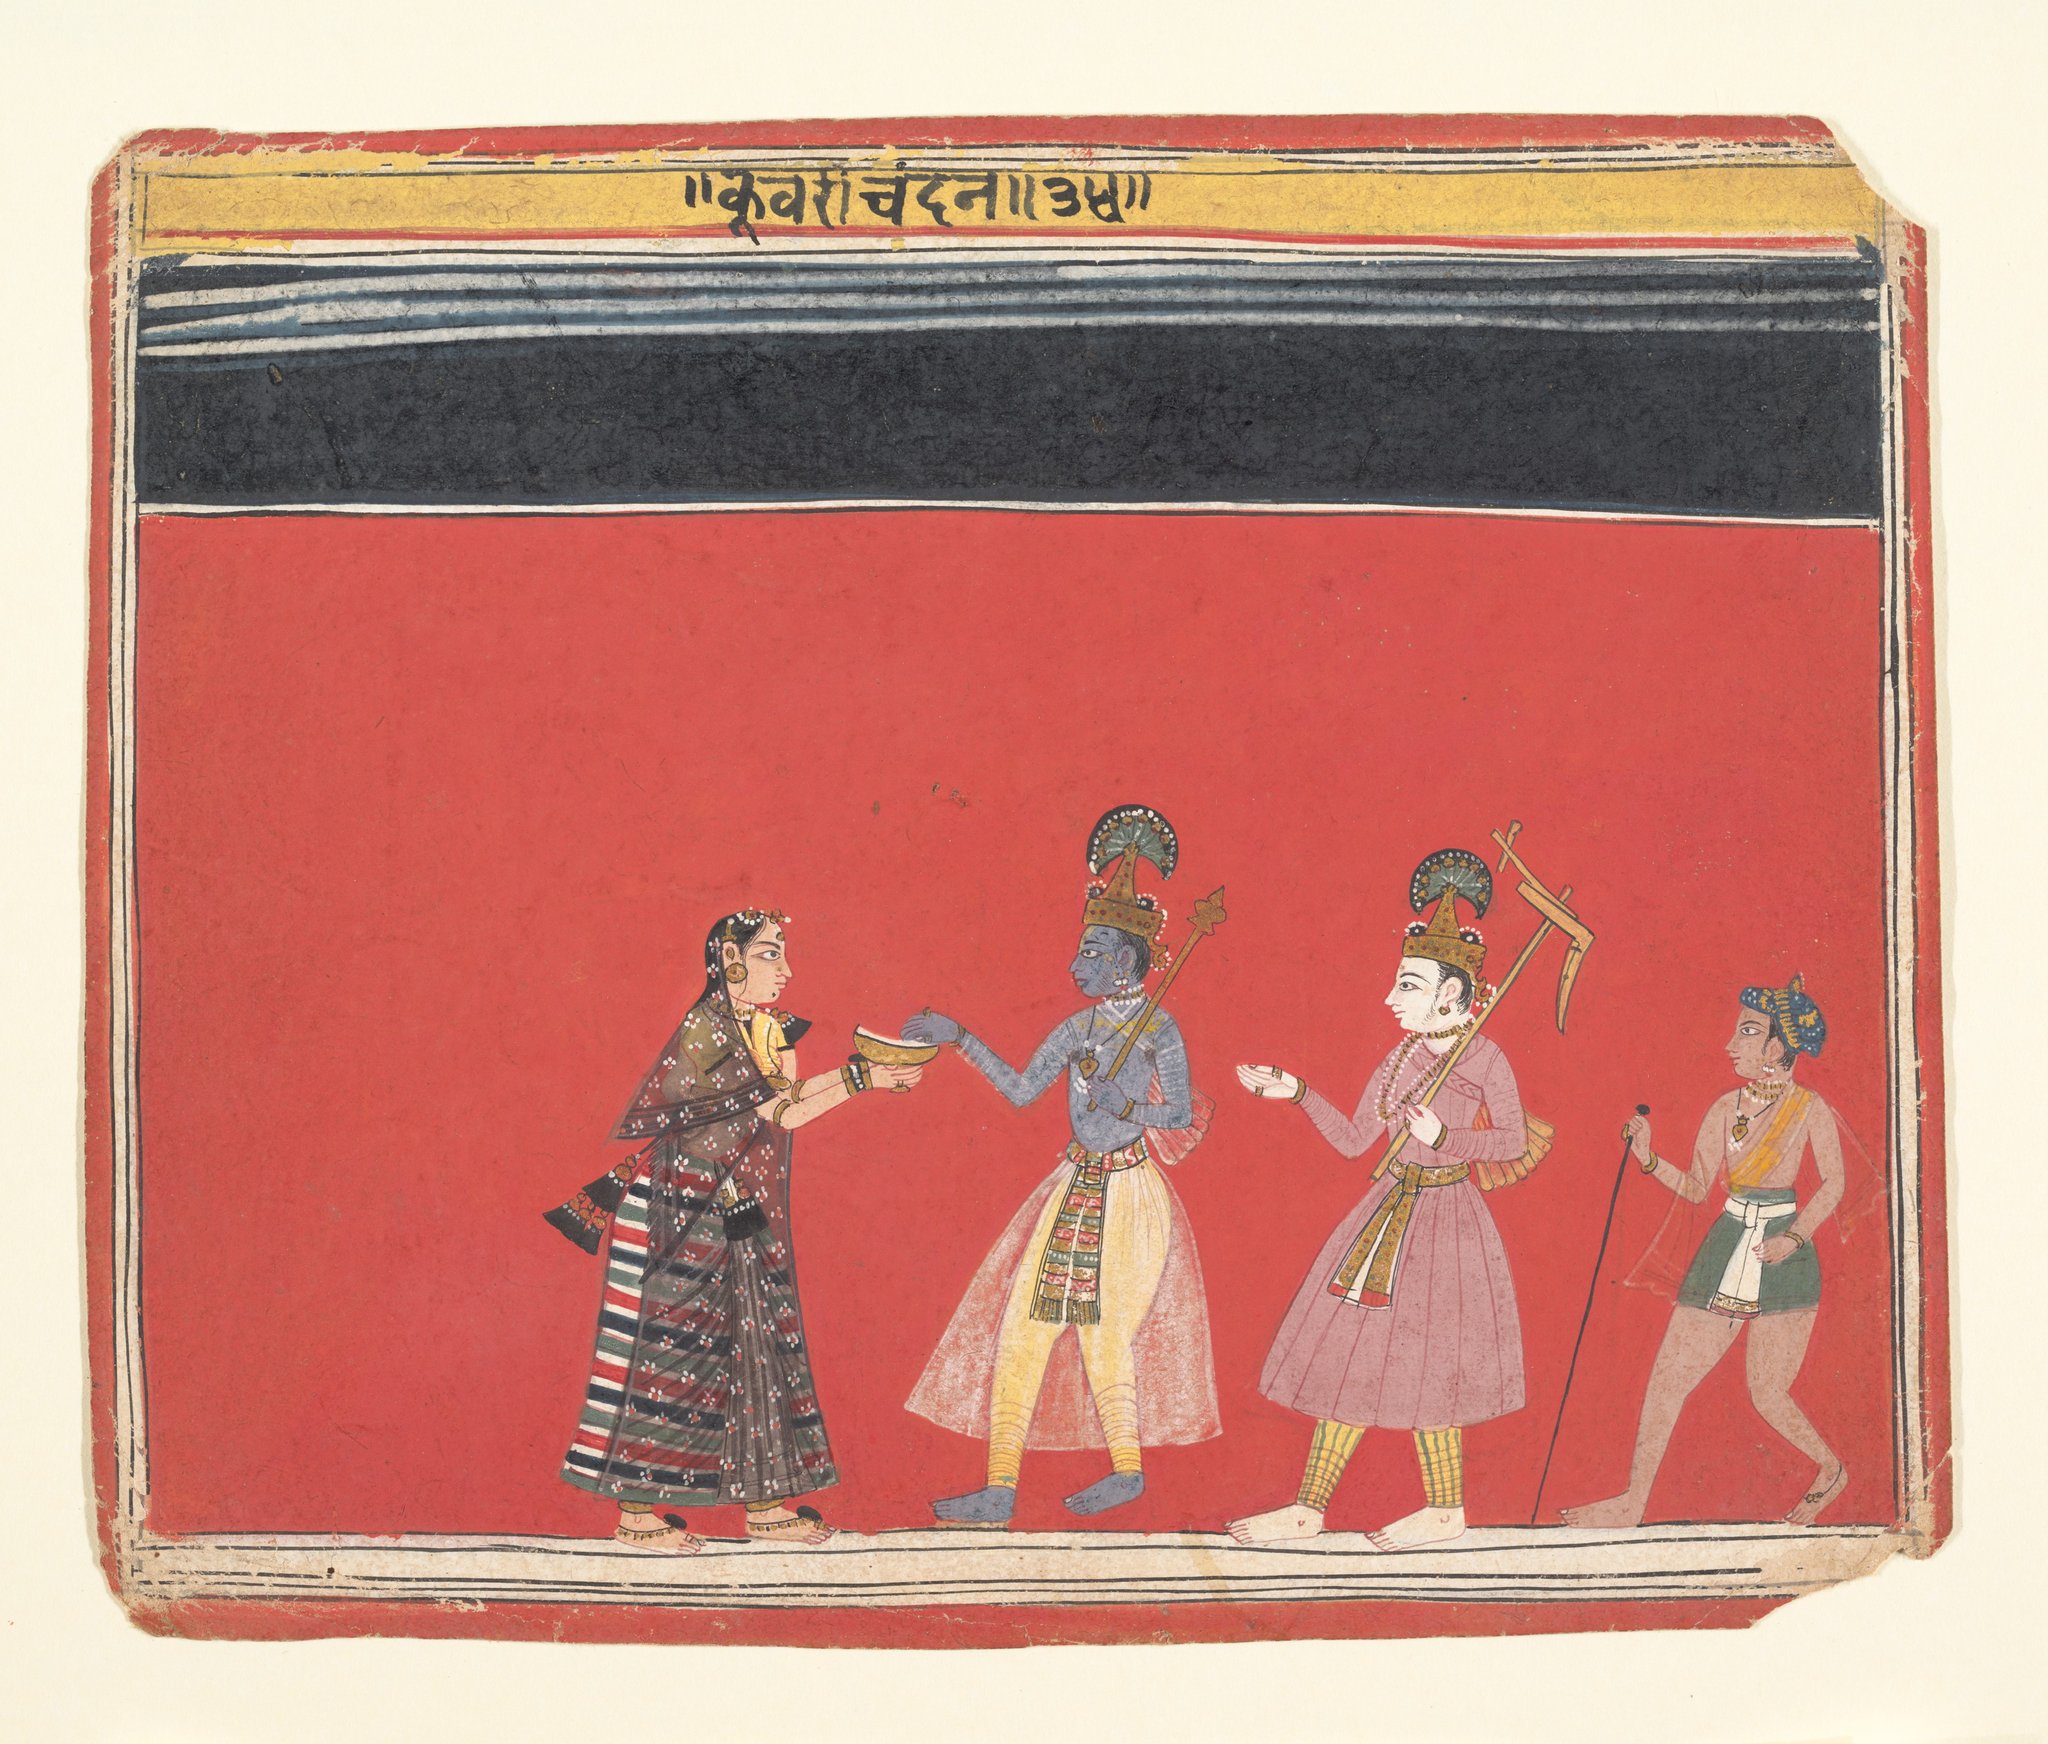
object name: folio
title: Krishna Accepts an Offering from the Hunchbacked Woman Trivakra: Page from a Bhagavata Purana Series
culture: indian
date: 1650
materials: ink, paper, watercolor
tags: men,women,krishna